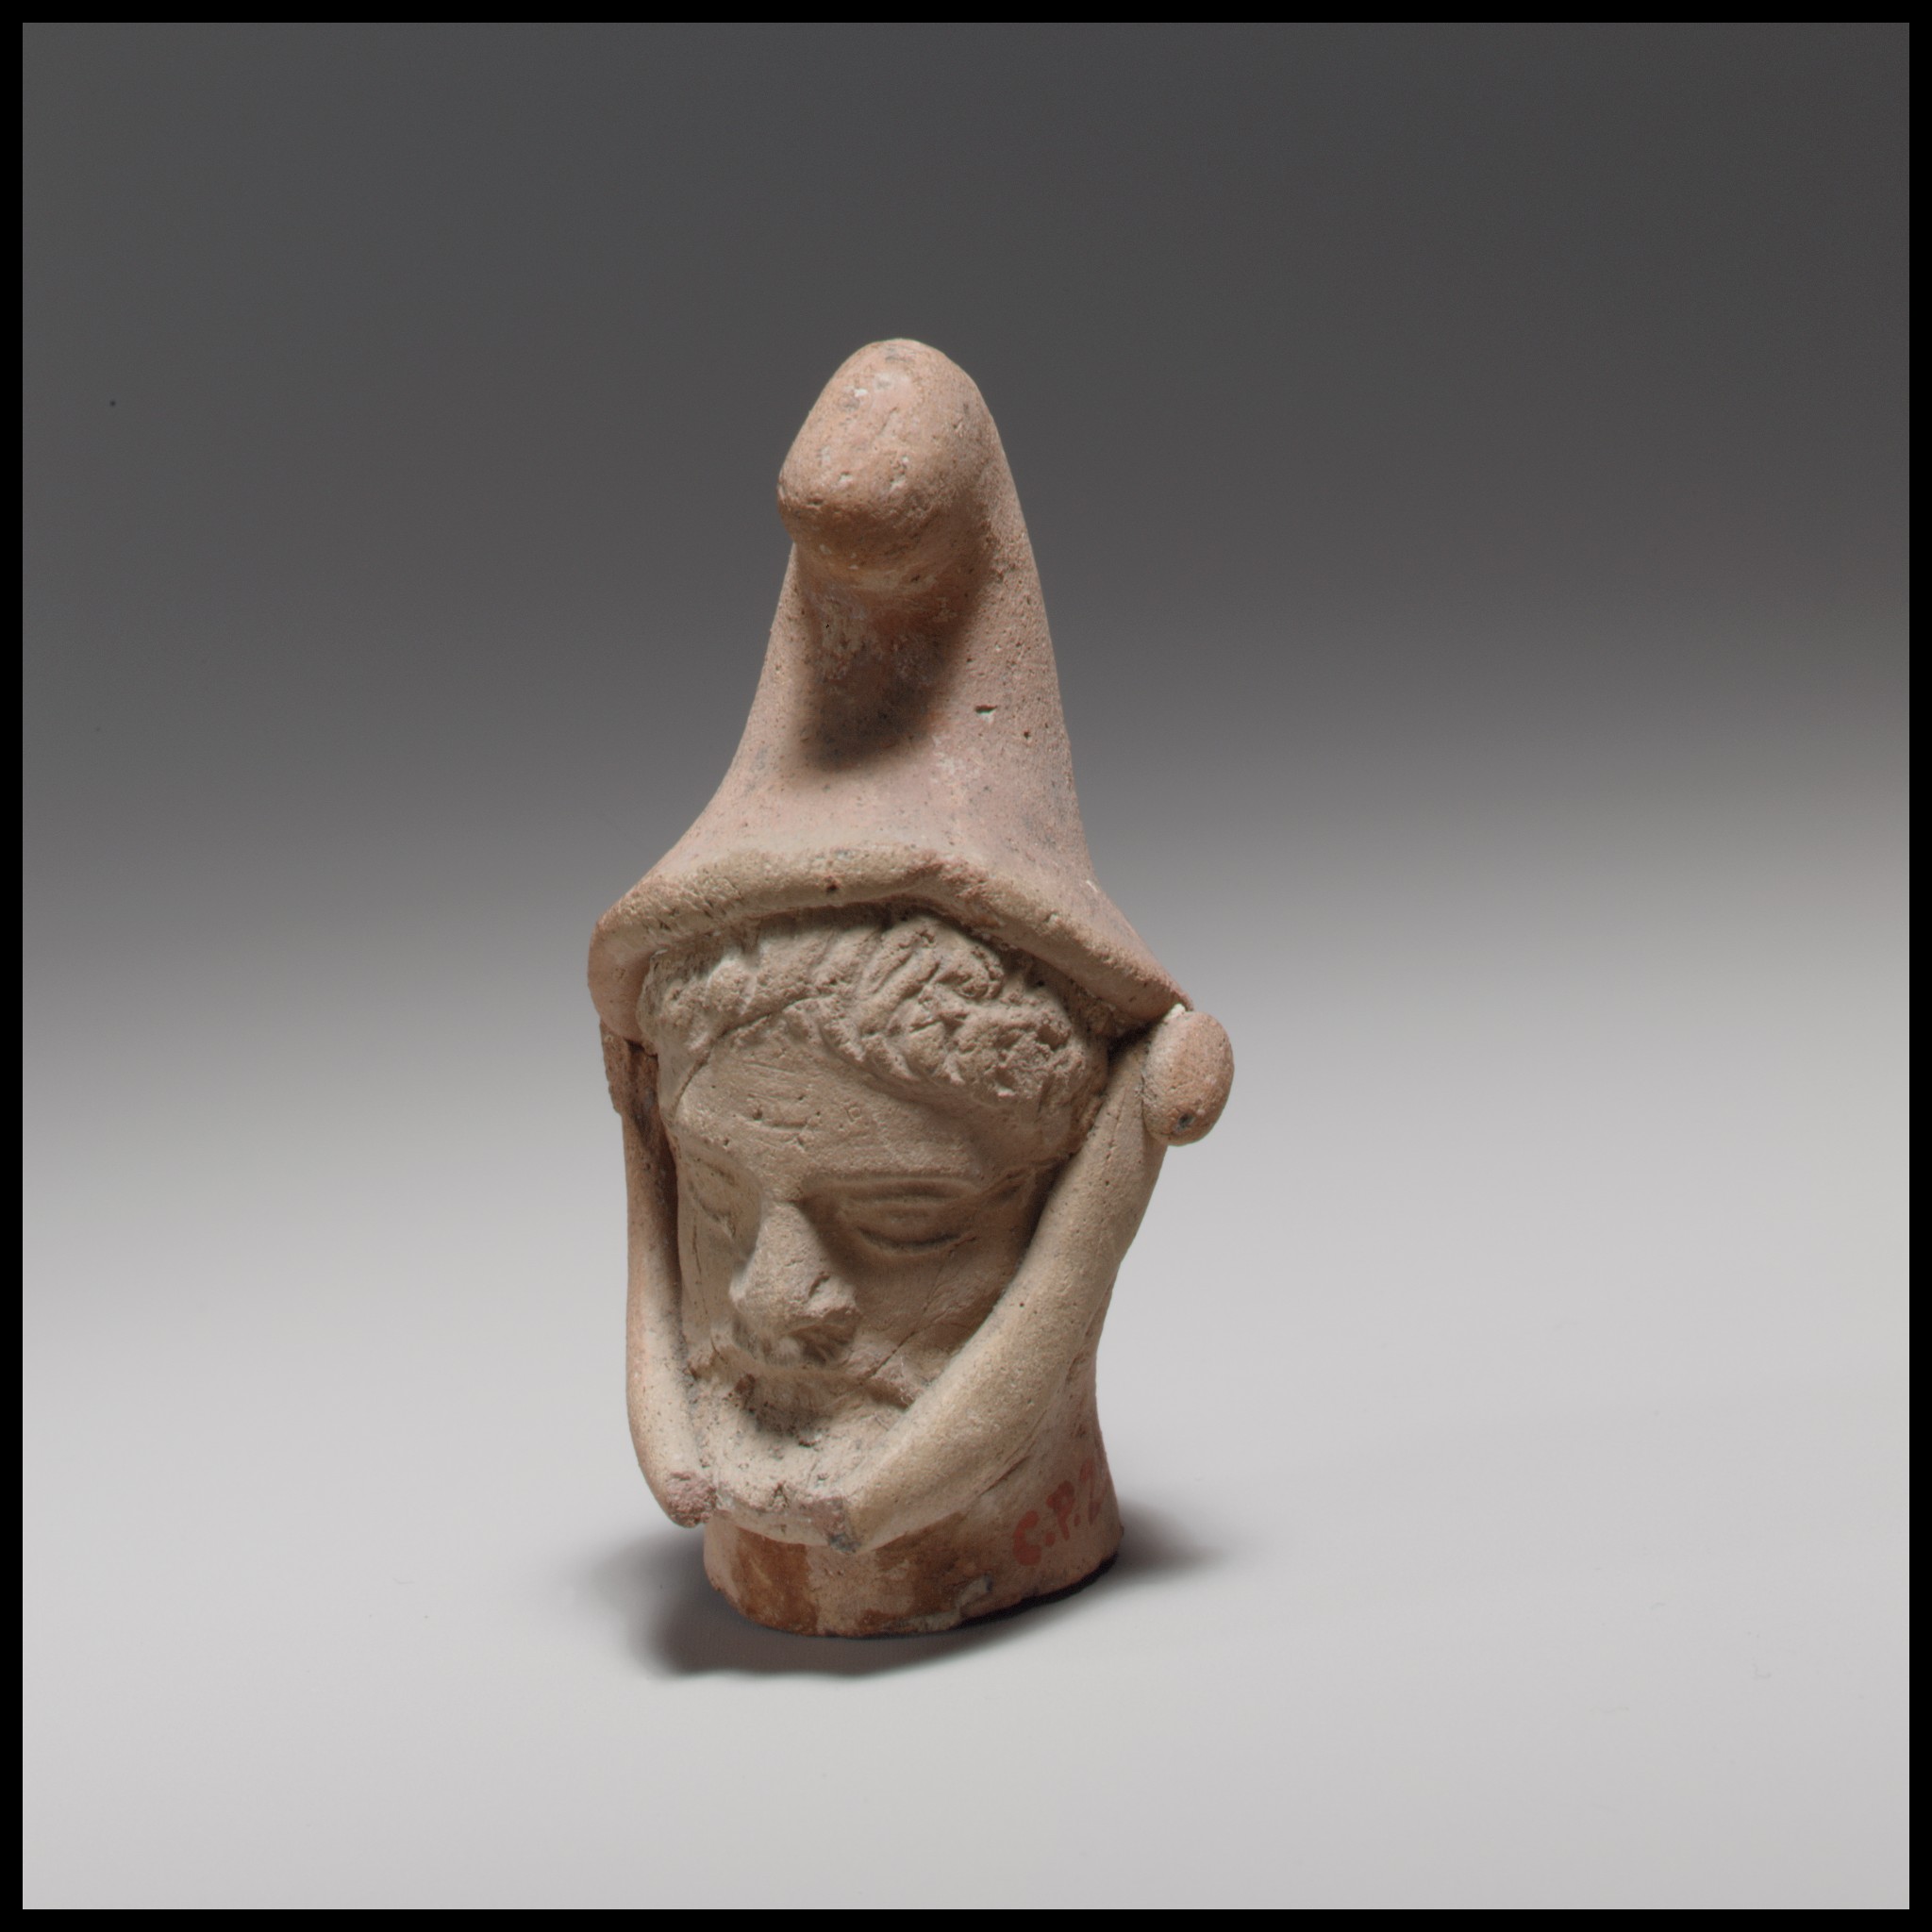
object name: head of a male votary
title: Male head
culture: cypriot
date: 400-201 BCE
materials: terracotta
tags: heads,men